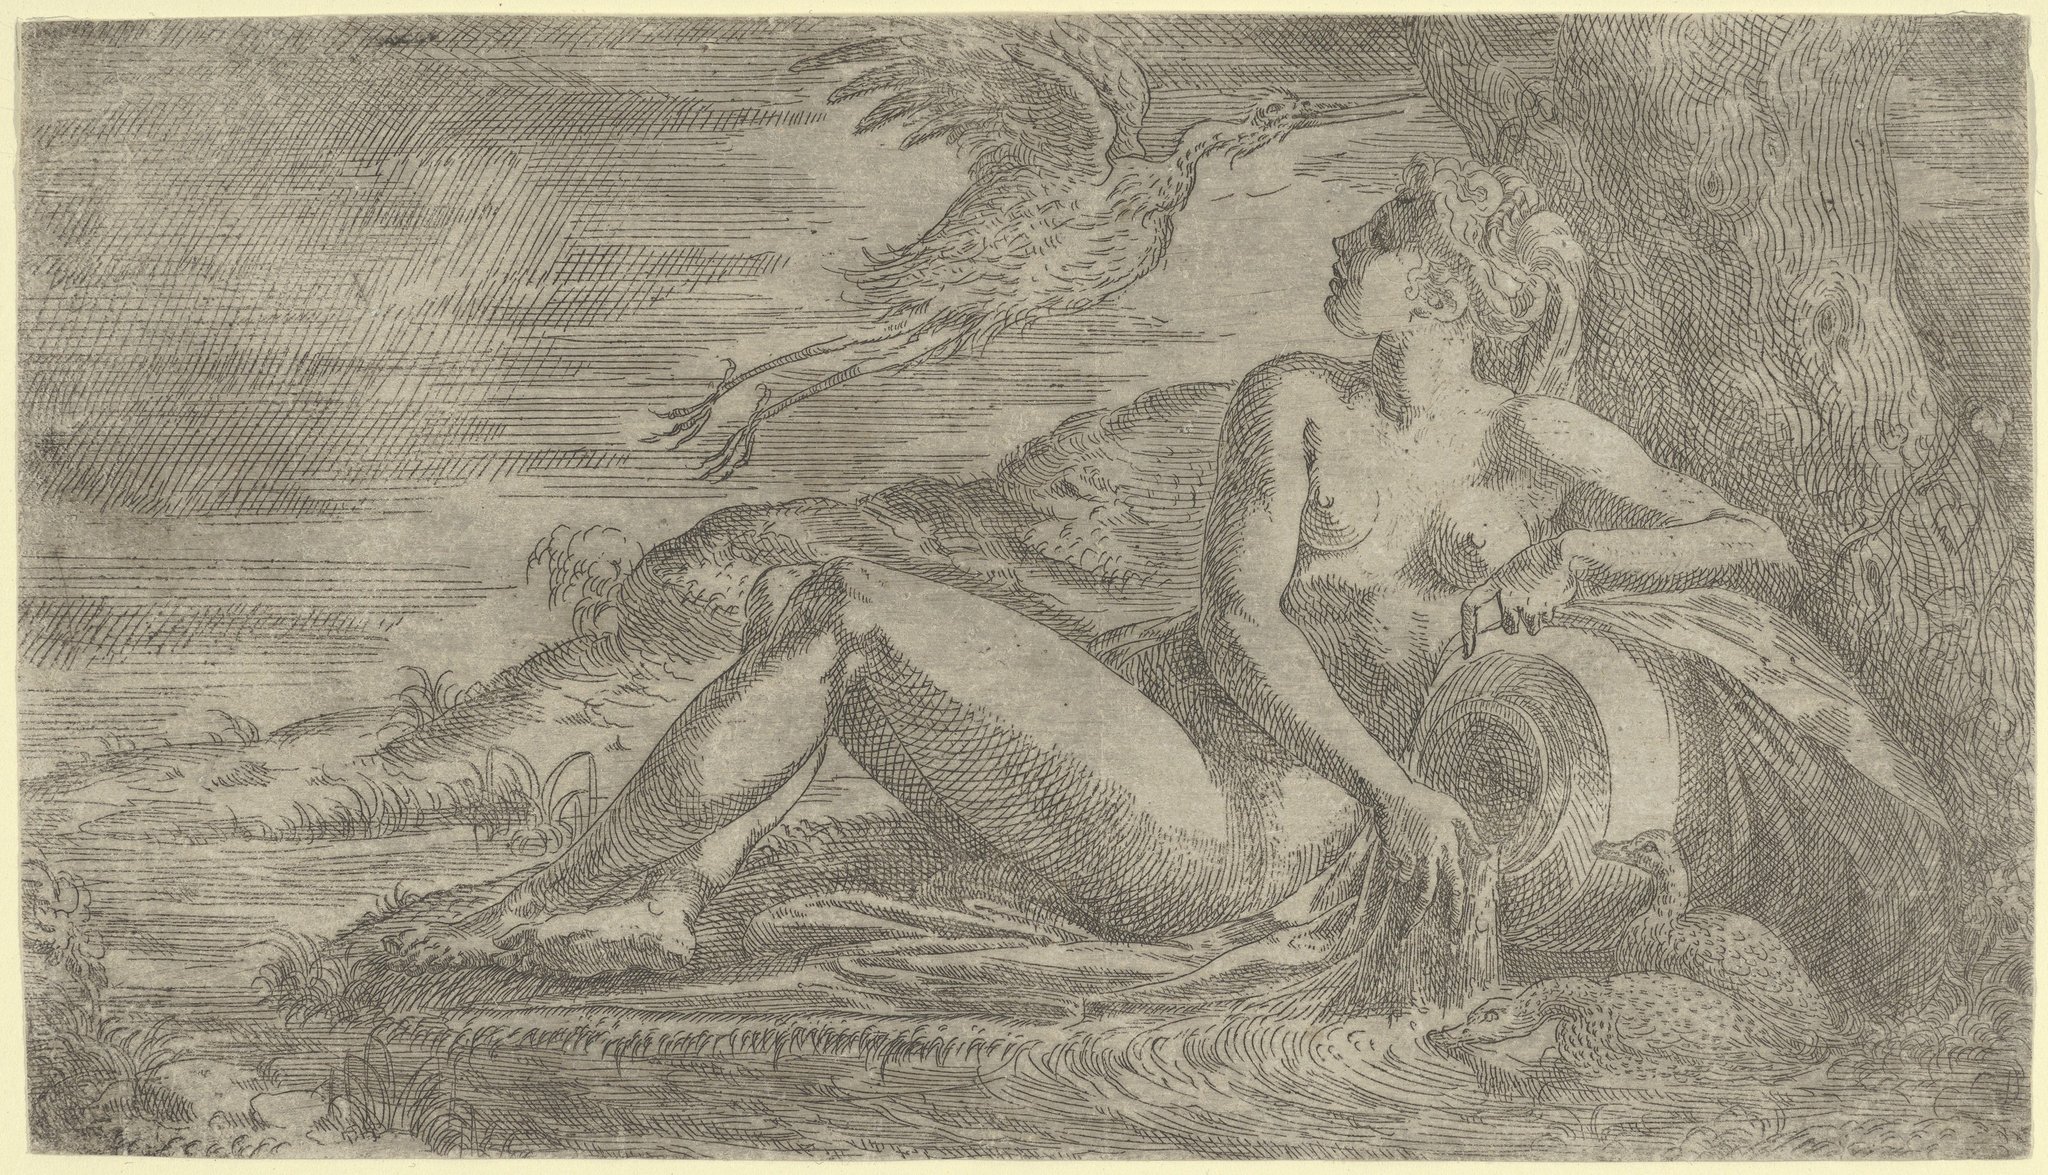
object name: print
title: Nymph Watching a Heron Flying Away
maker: léon davent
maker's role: artist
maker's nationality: french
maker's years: 1540-1556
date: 1542-1545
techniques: etching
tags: birds,nymphs